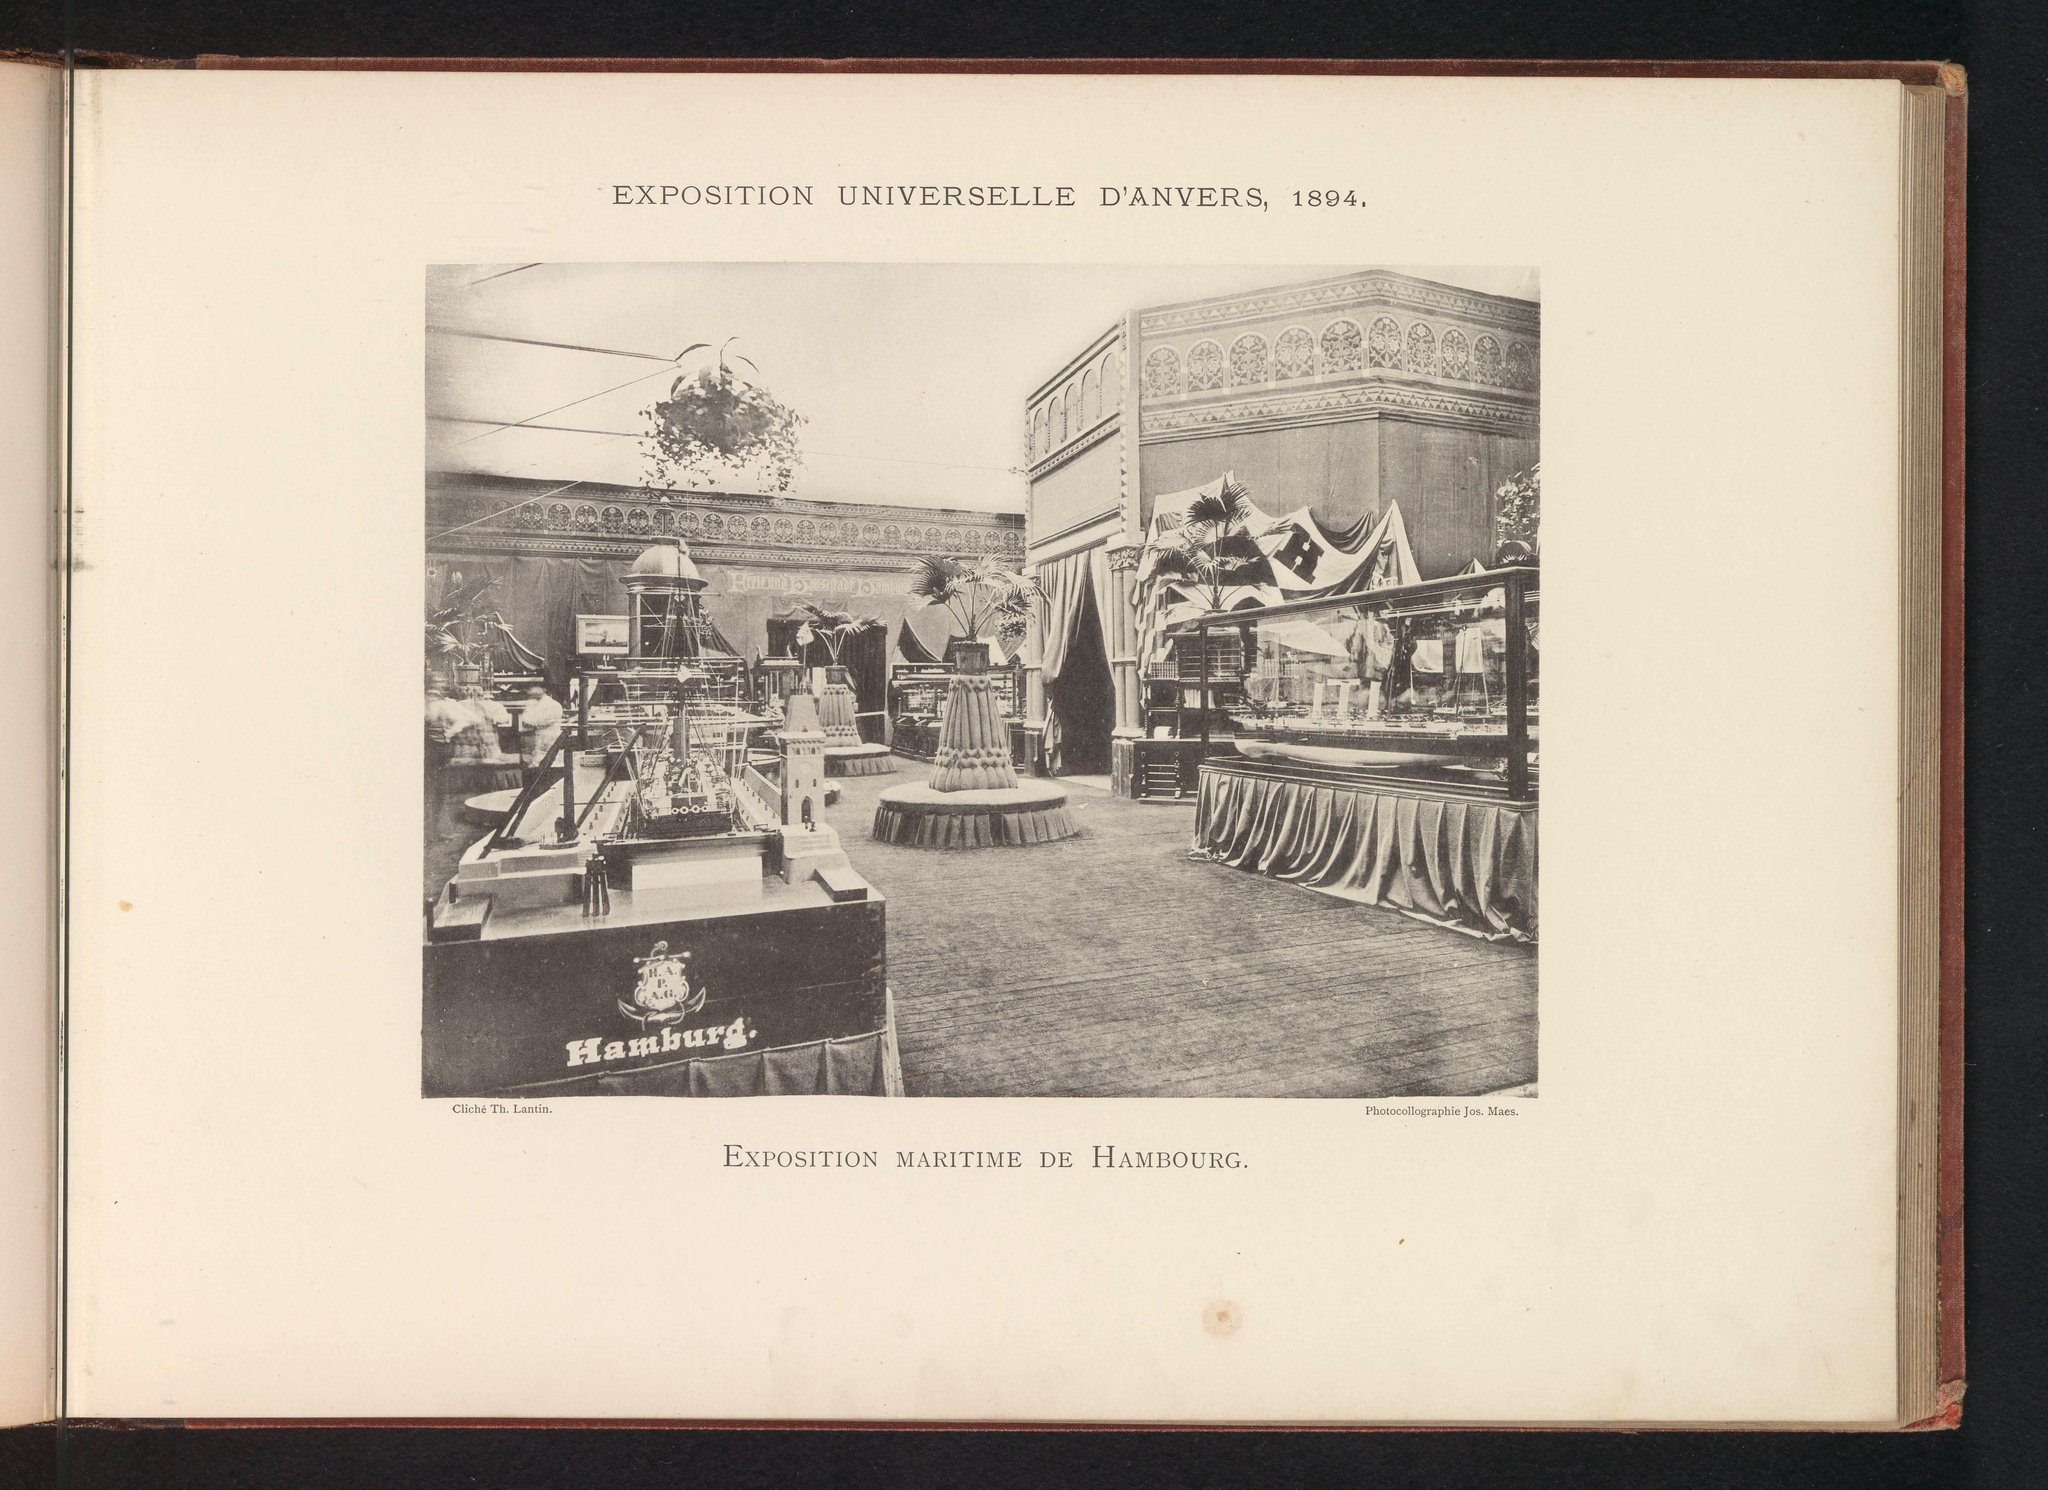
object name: photomechanical print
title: Expositie van maritieme objecten uit Hamburg tijdens de wereldtentoonstelling te Antwerpen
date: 1894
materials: paper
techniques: photograph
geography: antwerp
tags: world fair, world exhibition, collection, exhibition, show, ship-model